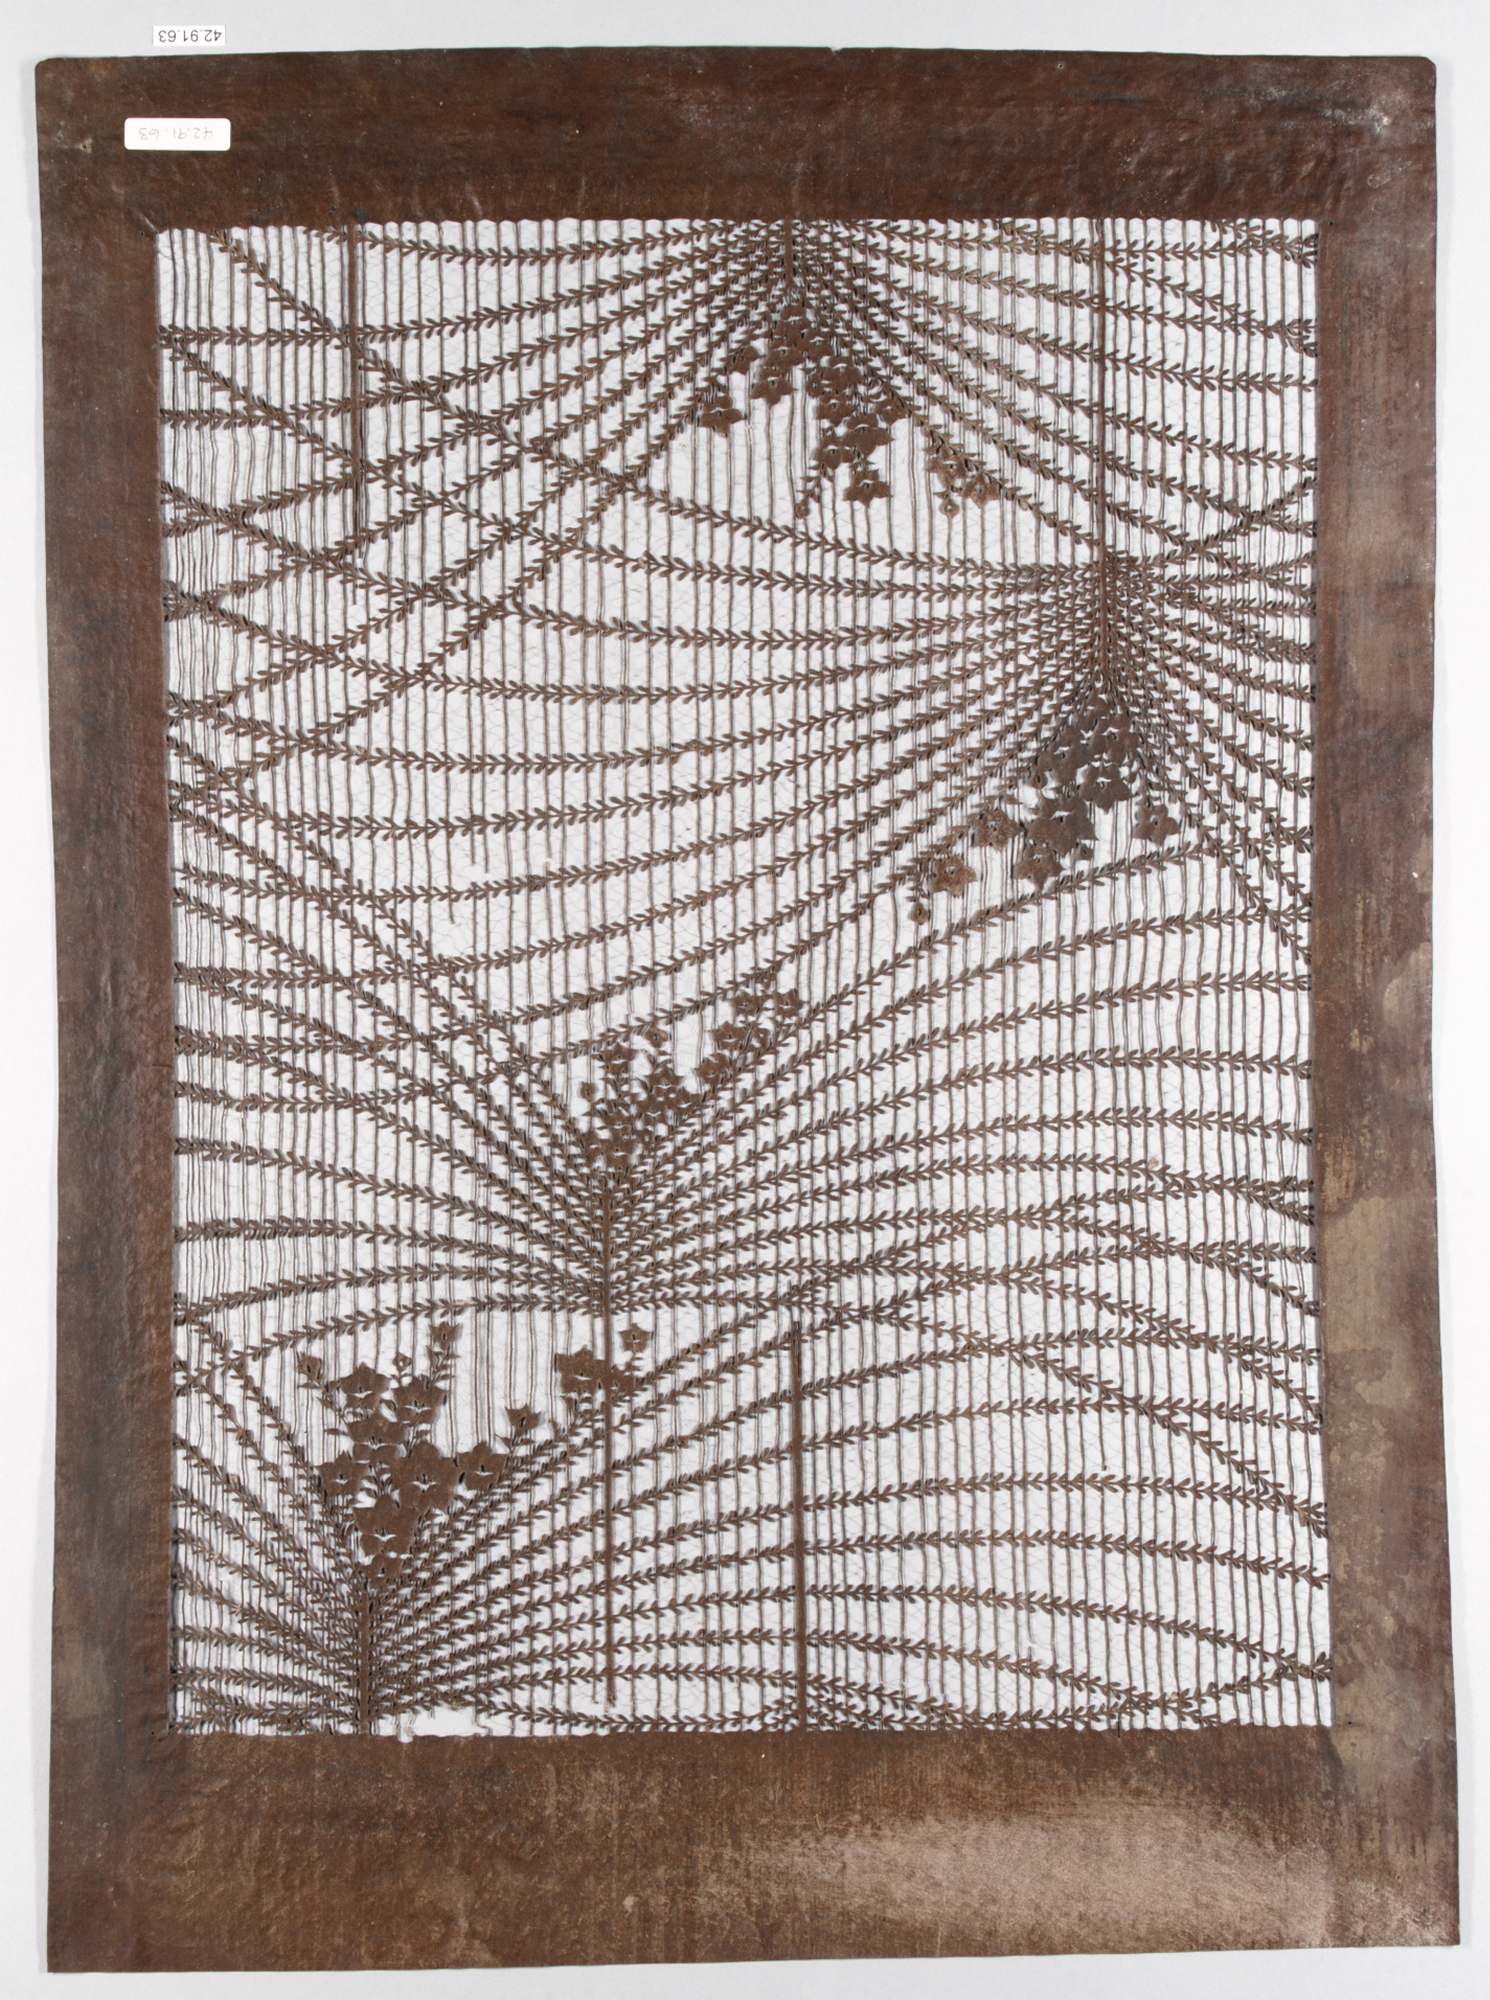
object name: stencil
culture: japanese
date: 1801-1900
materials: paper, silk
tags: flowers